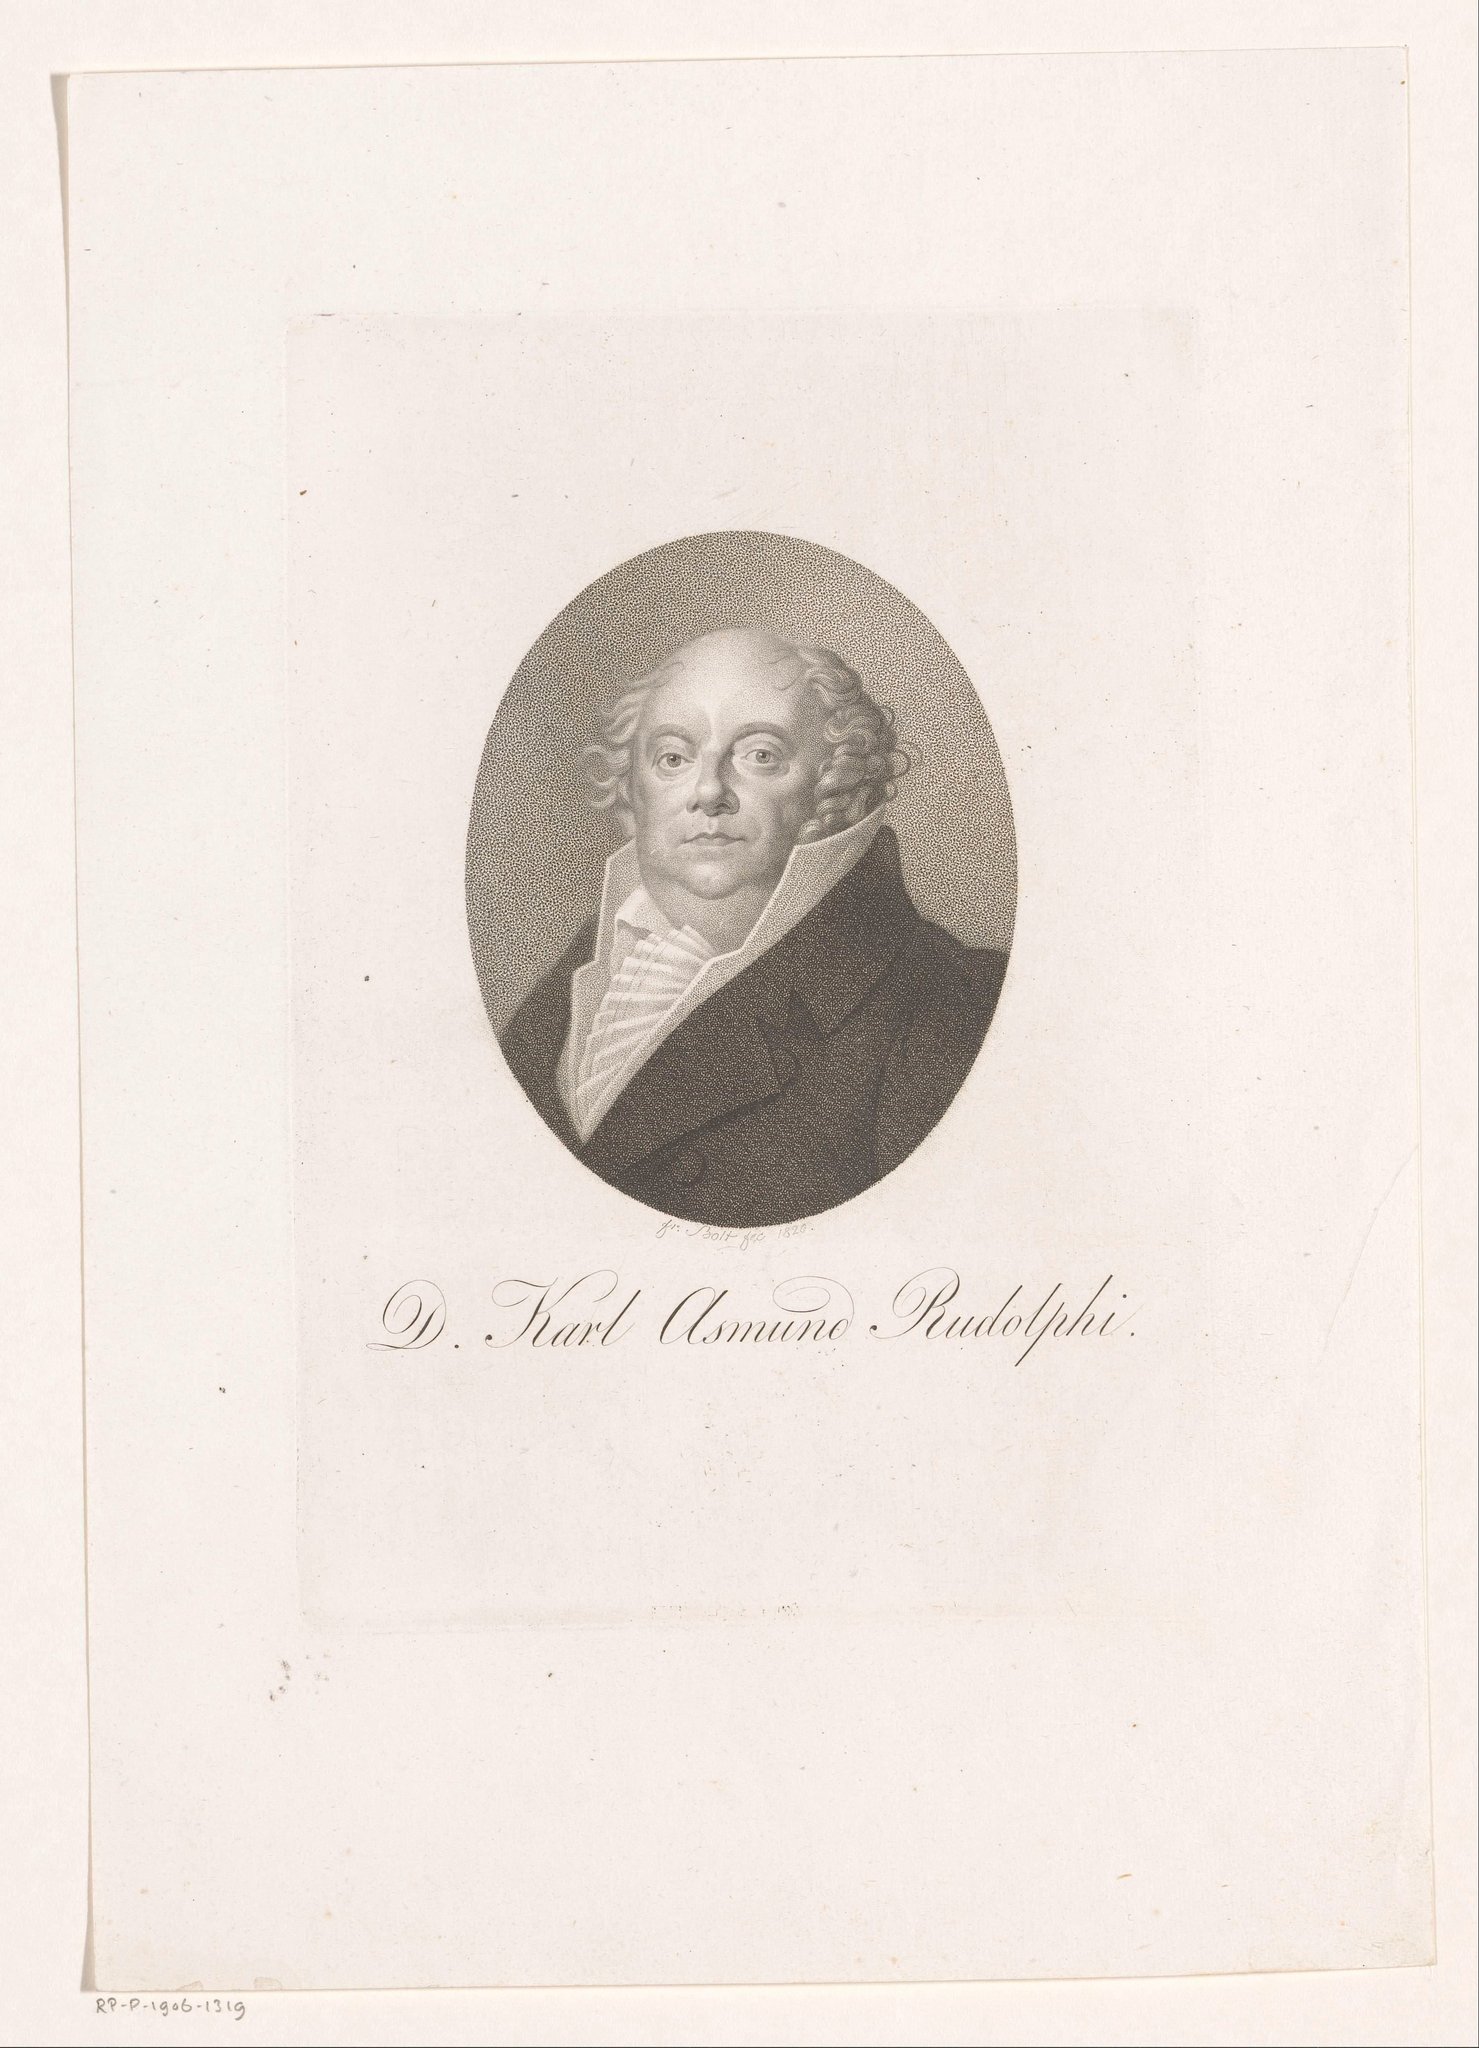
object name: print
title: Portret van Karl Asmund Rudolphi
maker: johann friedrich bolt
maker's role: print maker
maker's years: 1769-1836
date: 1820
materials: paper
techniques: stippling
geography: berlin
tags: berlin, historical persons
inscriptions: collector's mark: Lugt 2228